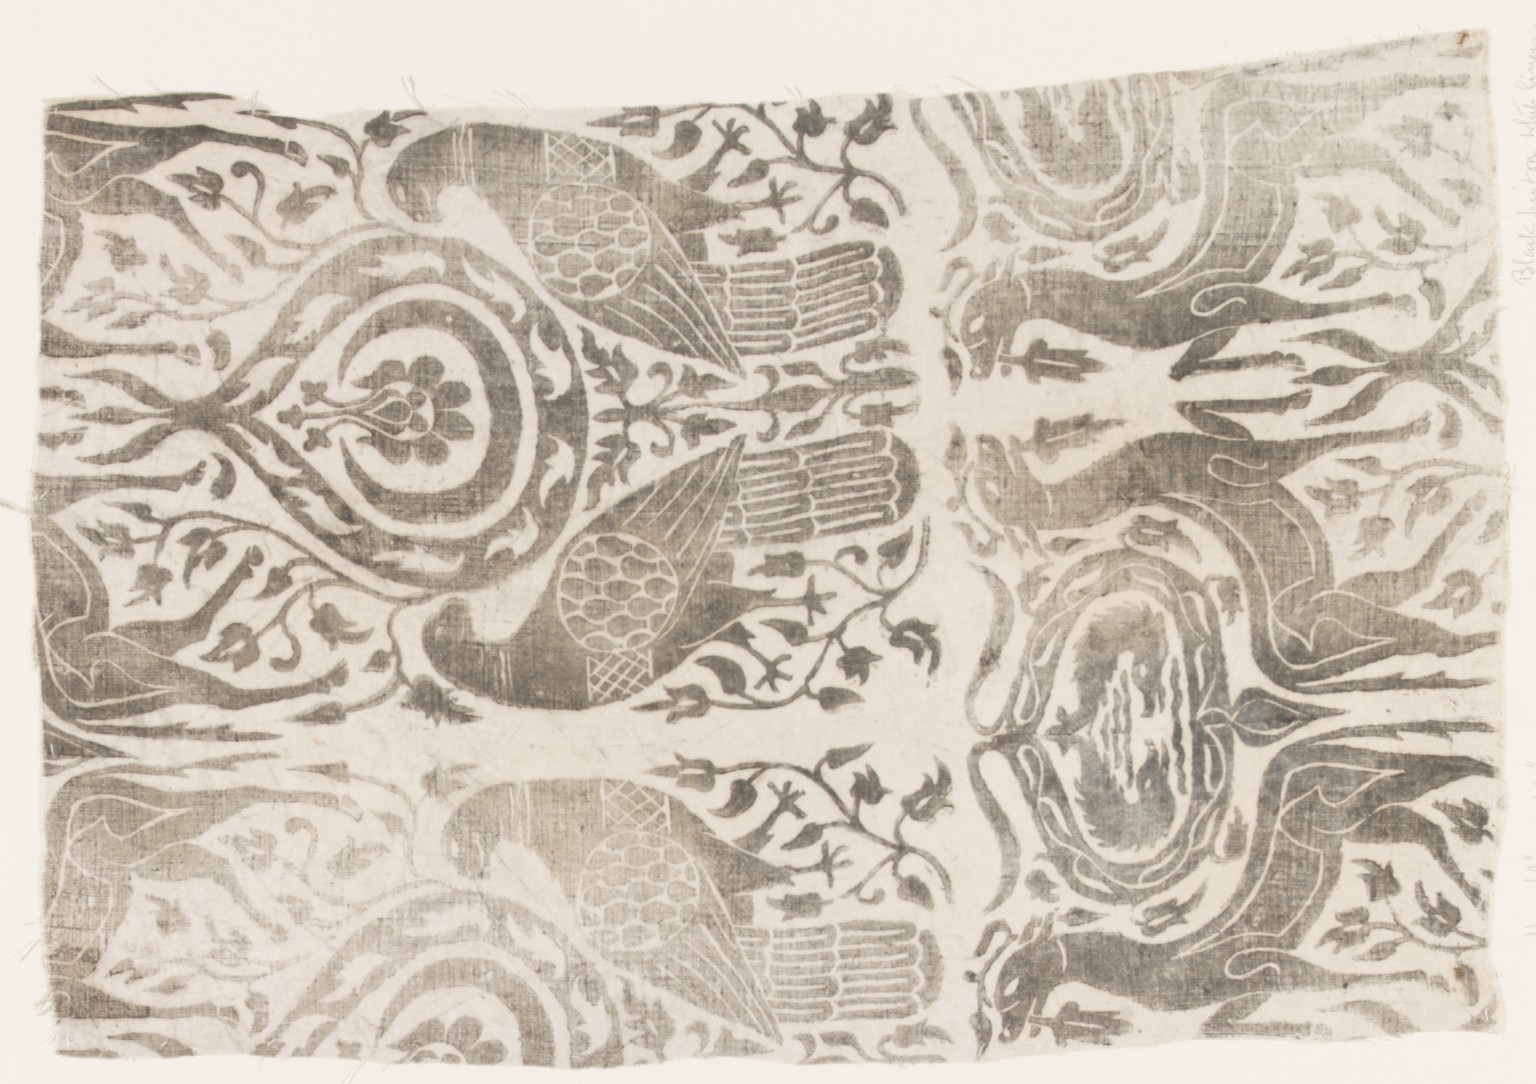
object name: fragment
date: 1301-1400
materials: linen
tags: animals,birds